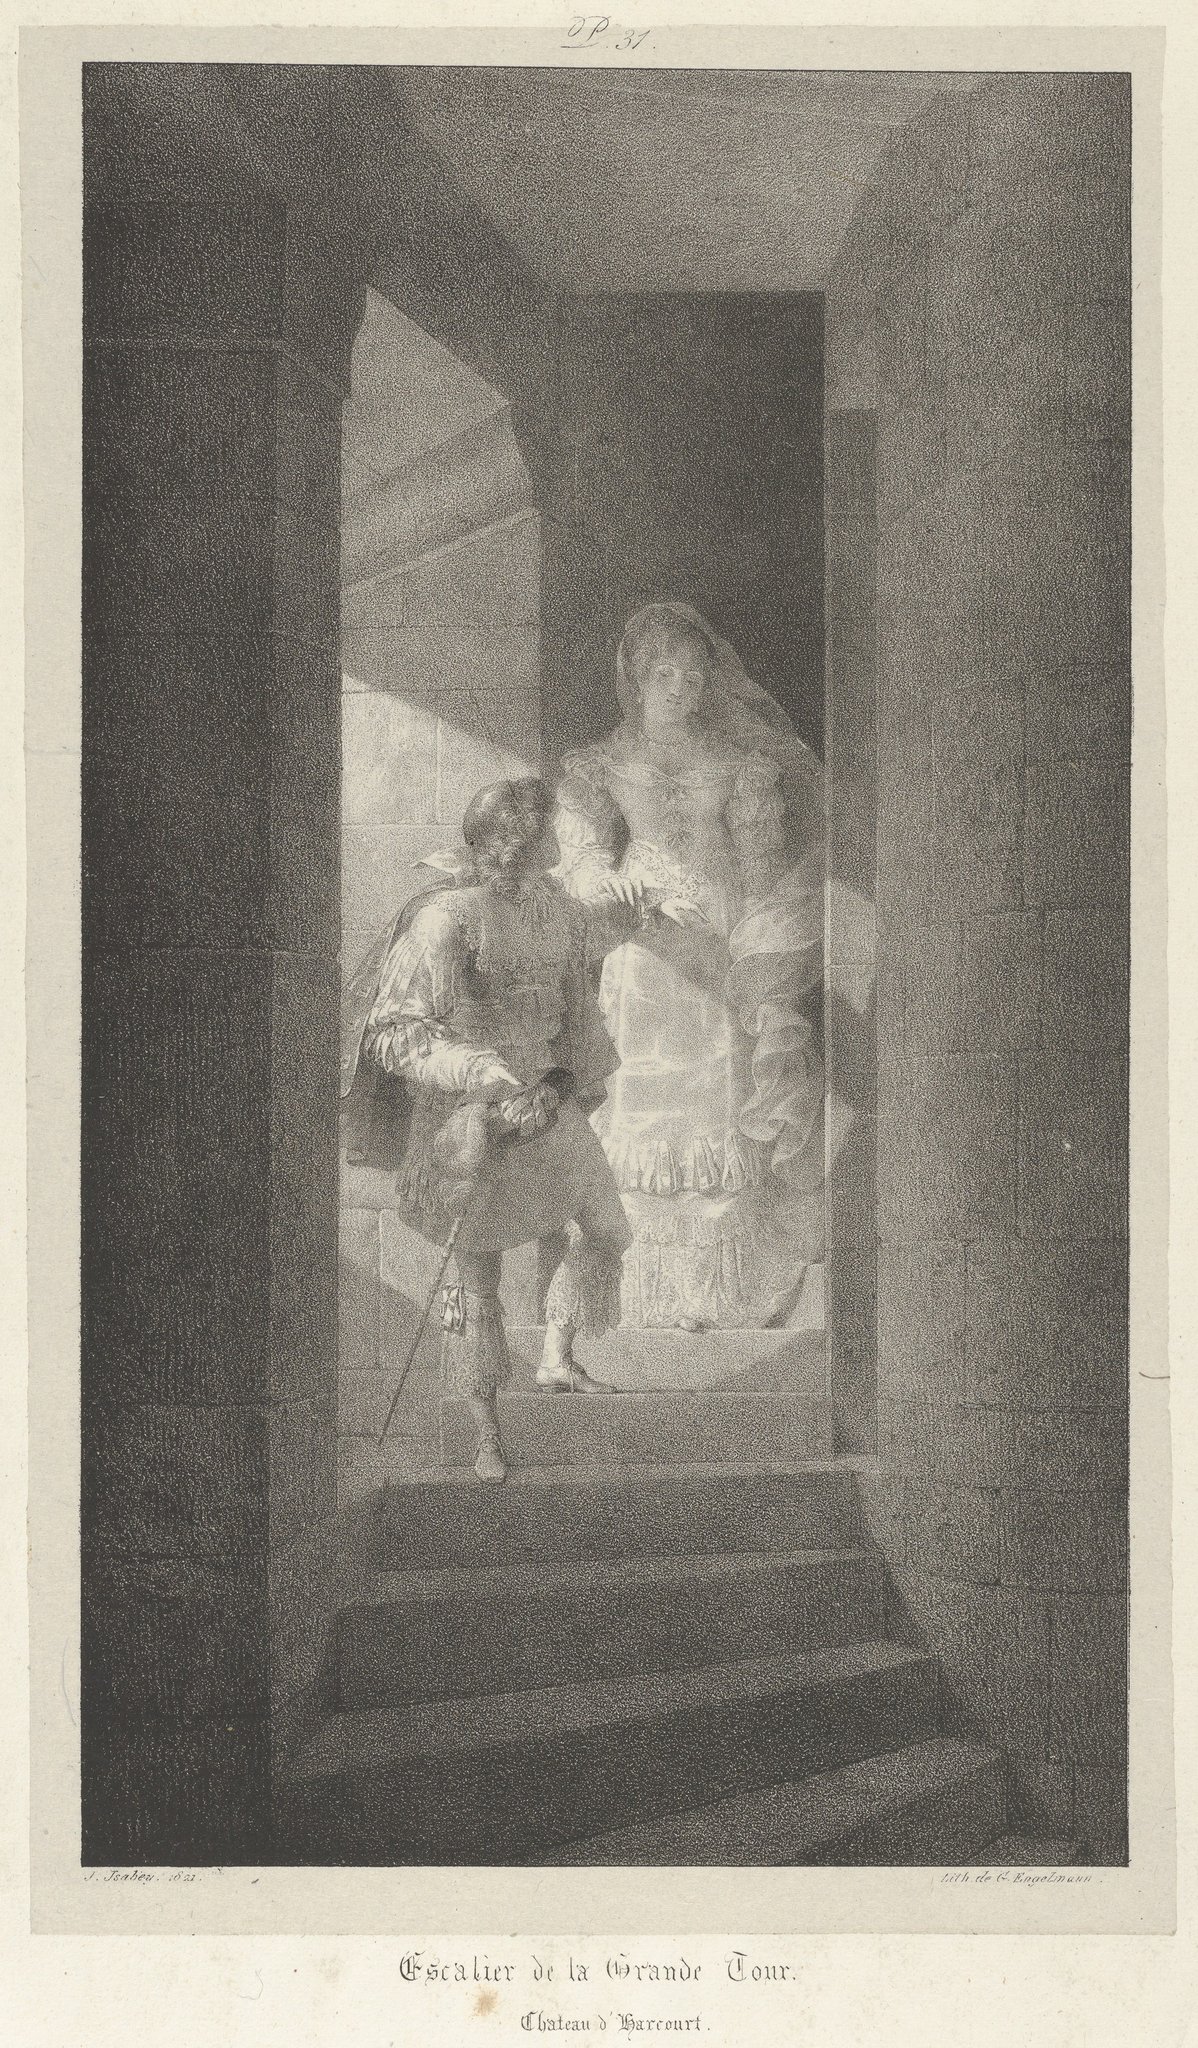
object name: print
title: Staircase of the Grand Tower, Harcourt Castle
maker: jean-baptiste isabey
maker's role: artist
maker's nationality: french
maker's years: 1767-1855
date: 1818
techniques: lithograph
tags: stairs,men,women